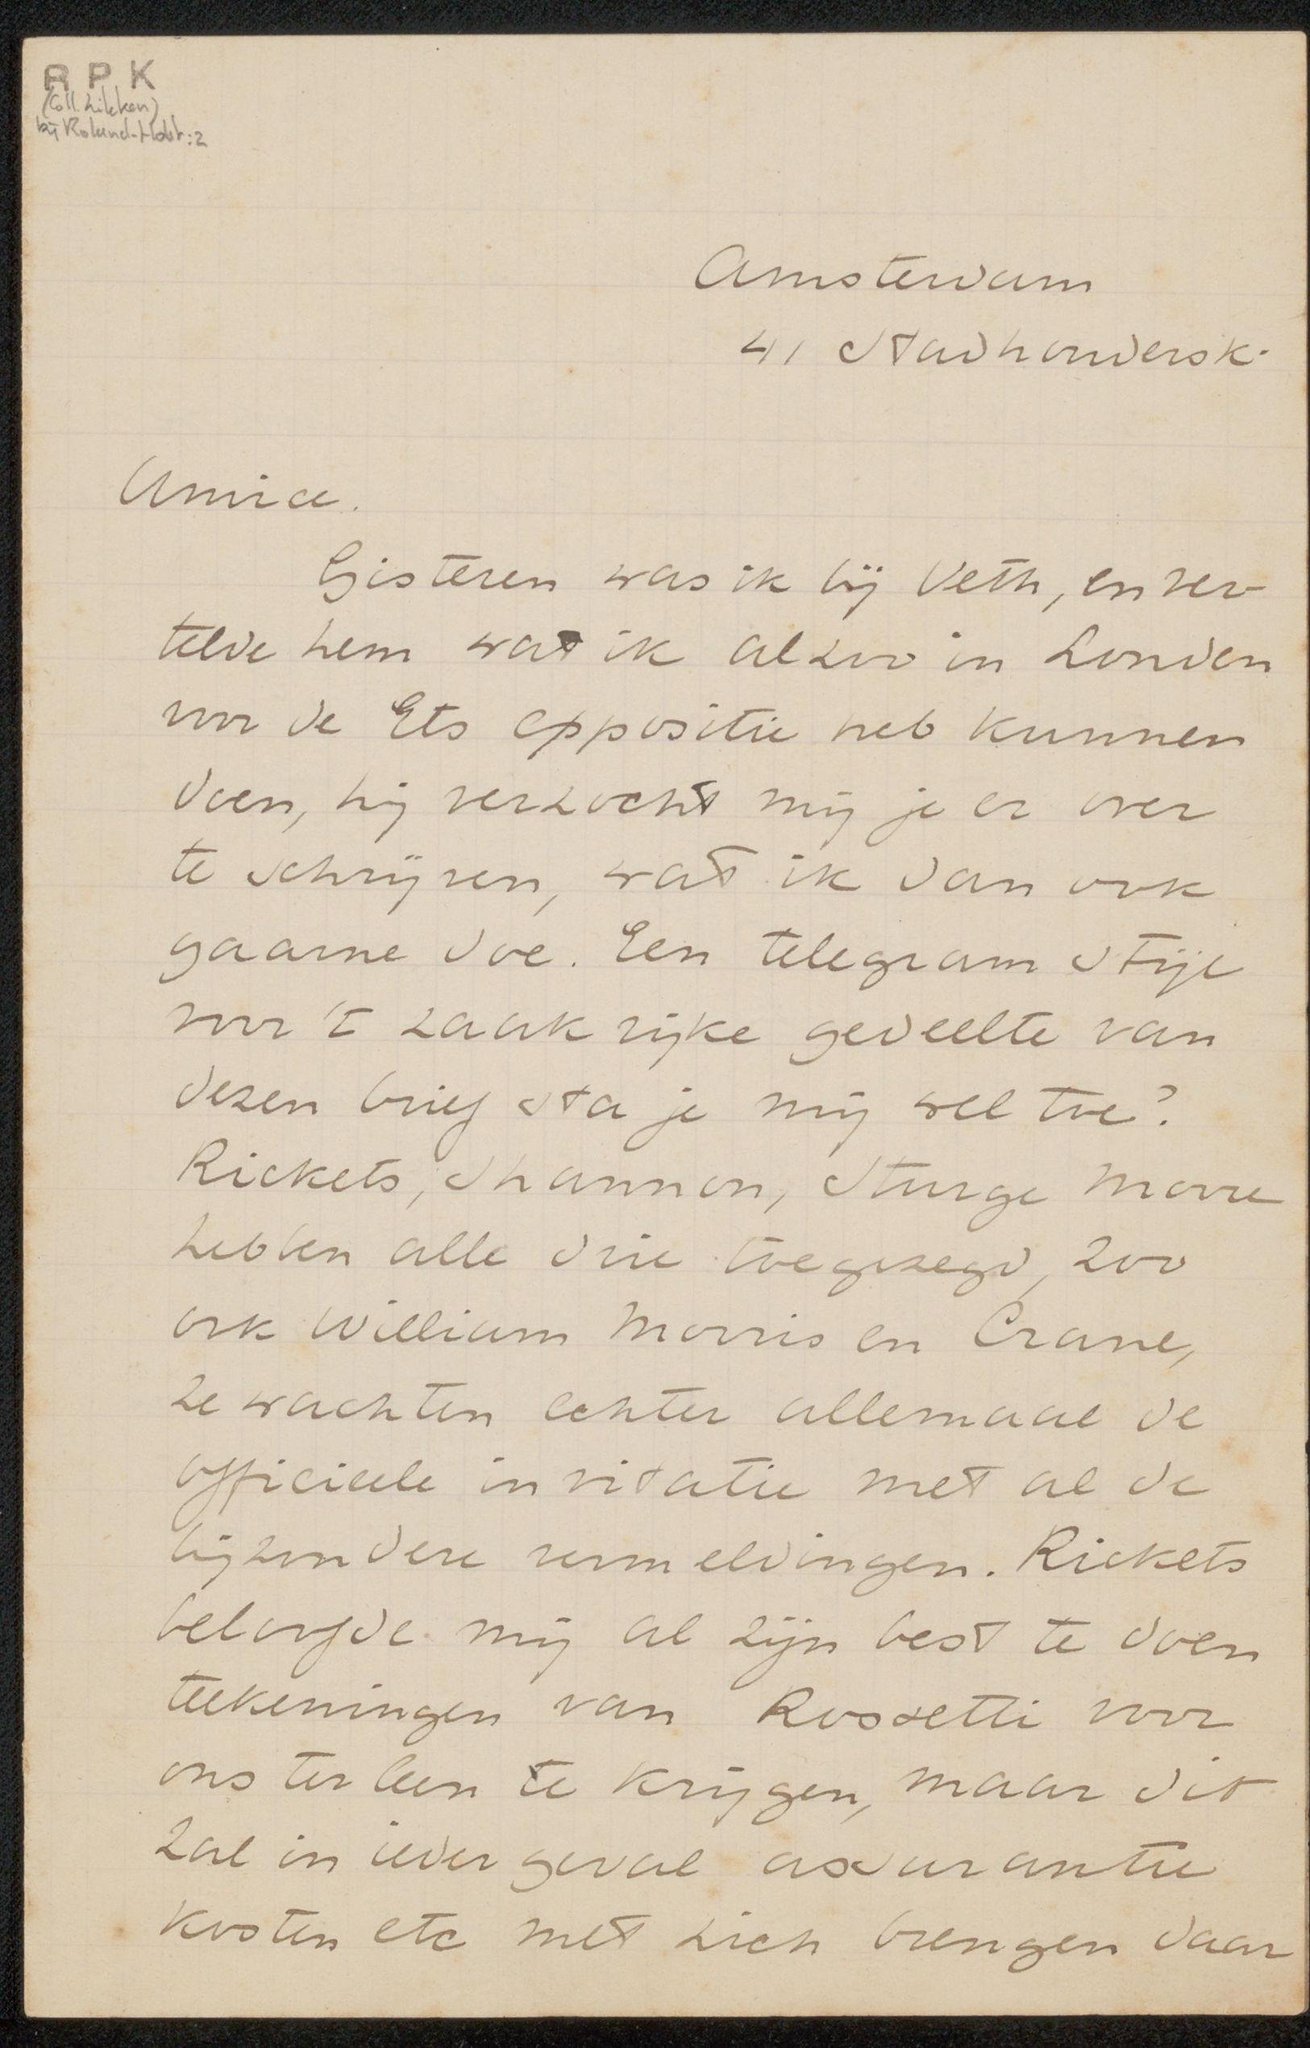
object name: letter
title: Brief aan Philip Zilcken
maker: richard nicolaüs roland holst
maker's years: 1868-1938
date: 1878-1930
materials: ink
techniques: pen, writing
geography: amsterdam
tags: amsterdam, jan veth, print maker, dwight case sturges, charles ricketts, painter, designer, william morris, charles haslewood shannon, liverpool, london, draughtsman, walter crane, paris, lucien pissarro, arthur gaskin, reginald savage, the hague, philip zilcken, drawing, the graphic arts, exhibition ~ art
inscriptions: collector's mark: ‘RPK’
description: Vormt doorlopende brief met RP-D-1982-43-ROLAND-HOLST-2A.